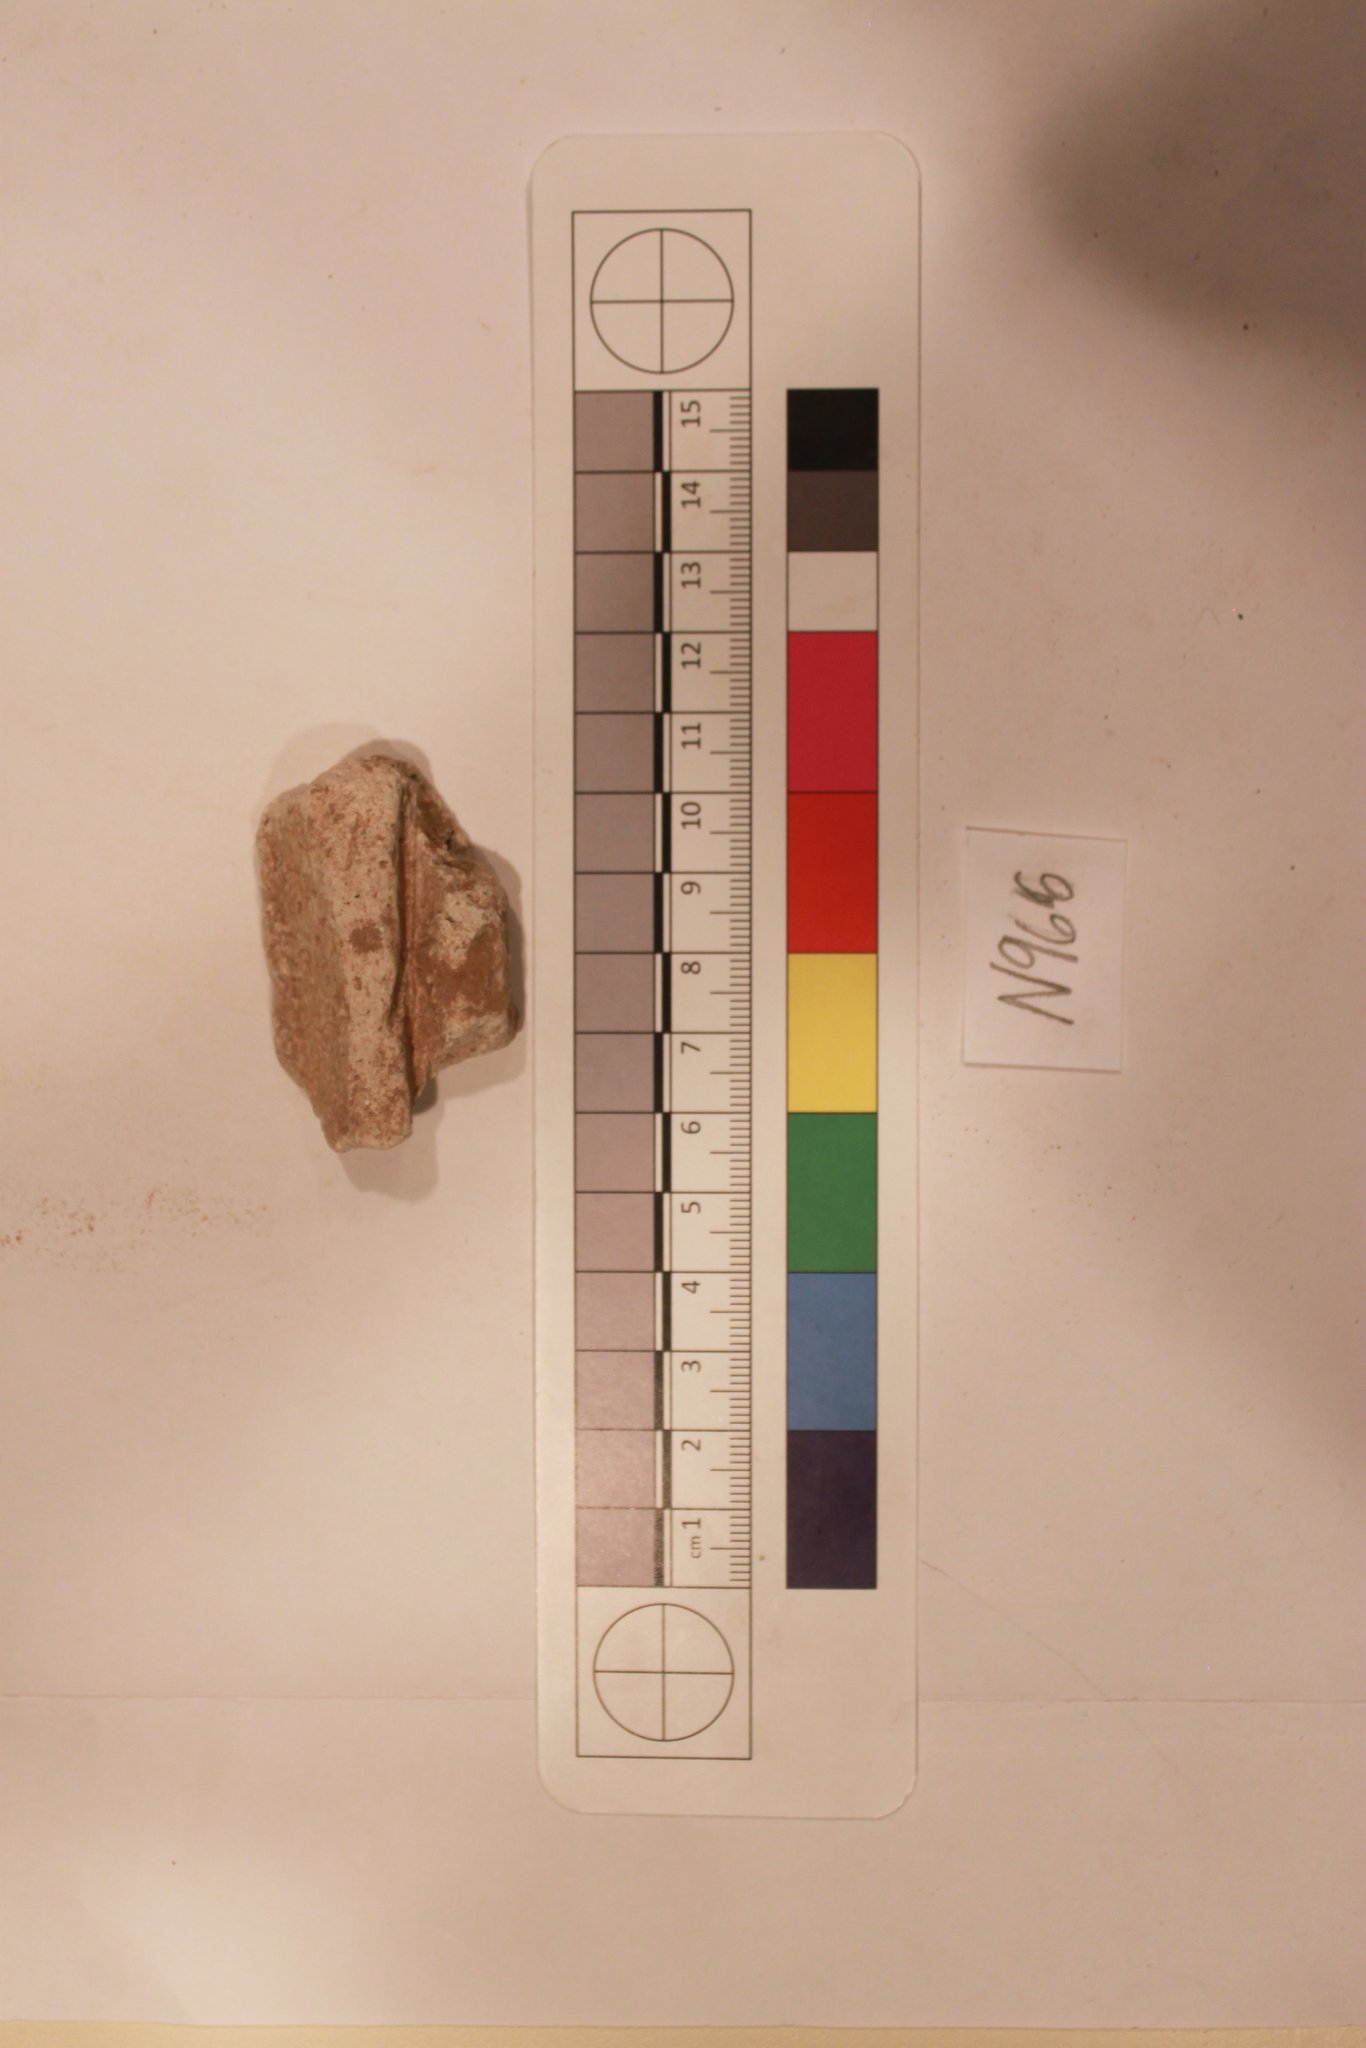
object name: fragment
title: Stucco Fragment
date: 701-1200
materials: plaster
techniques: carving, painting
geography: iran